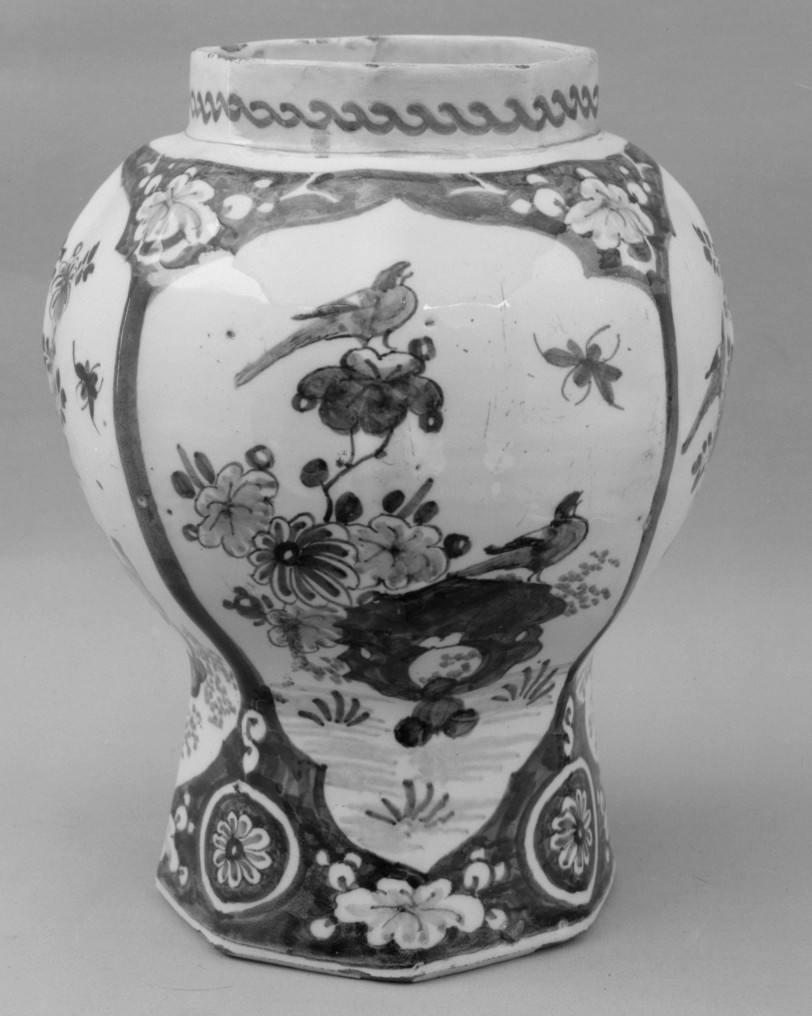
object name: vase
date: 1701-1800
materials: earthenware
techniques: glazing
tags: birds,insects,flowers